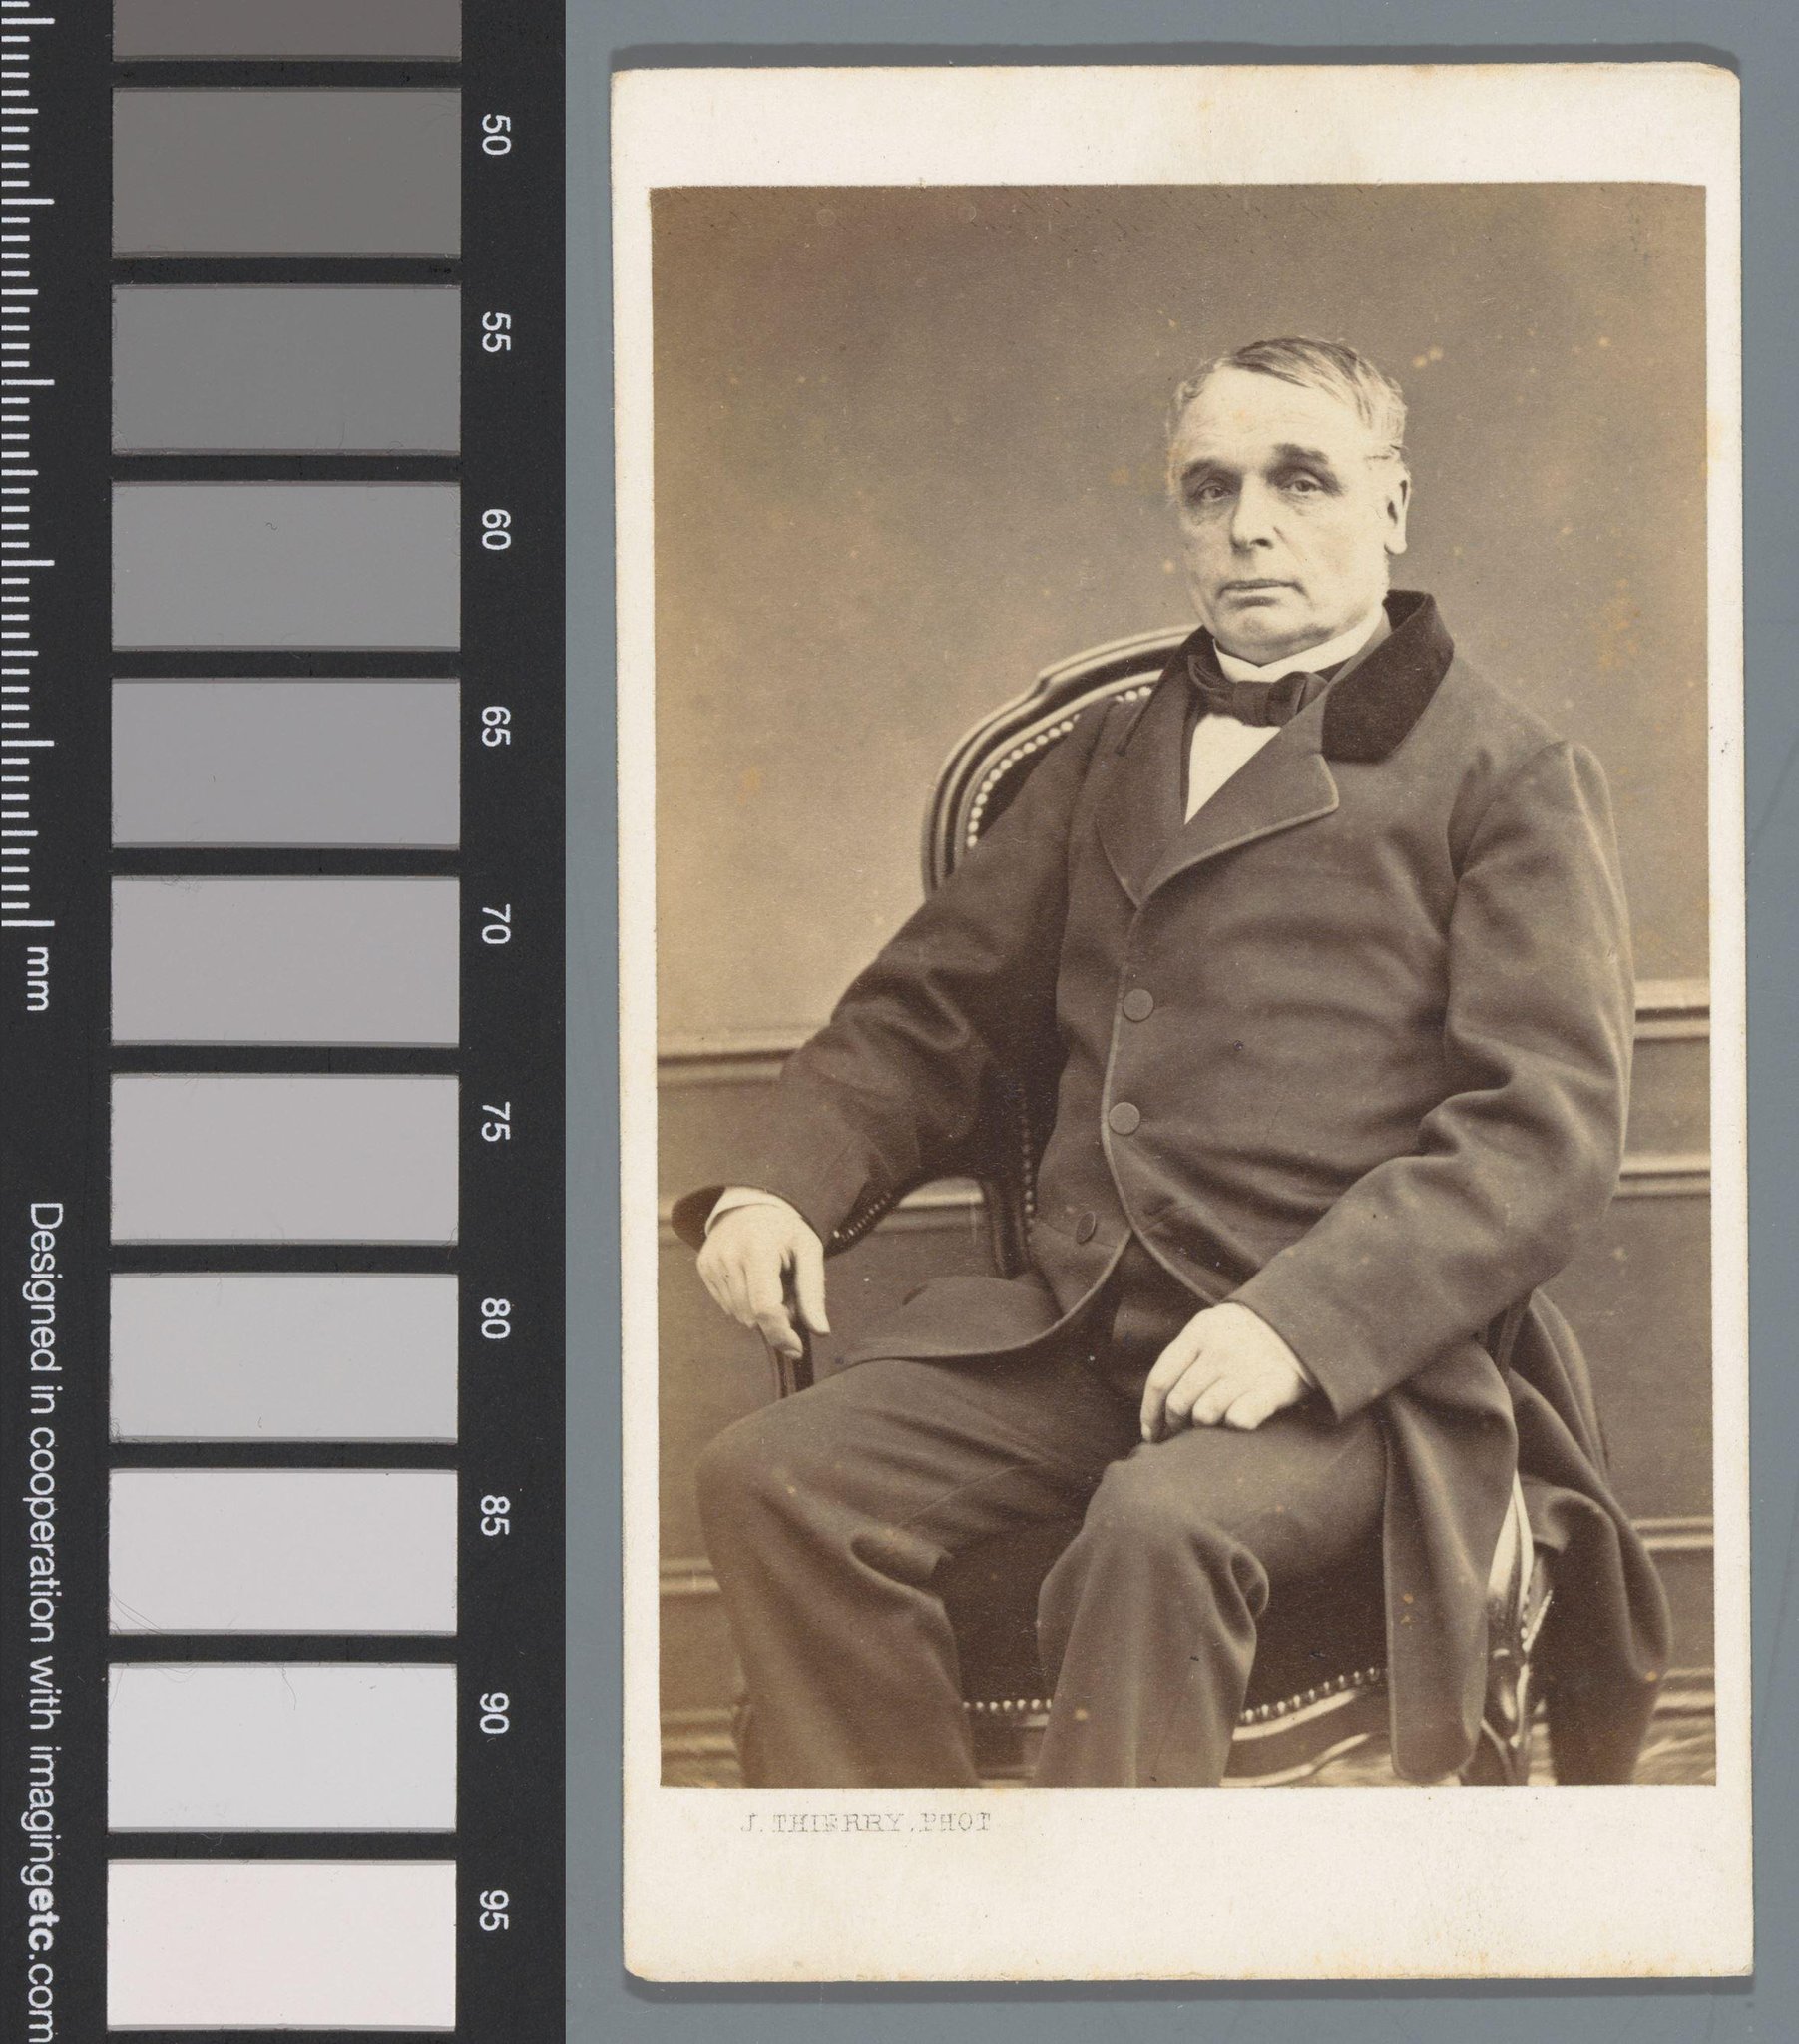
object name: photograph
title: Portret van een onbekende man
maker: jean-pierre thierry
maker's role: fotograaf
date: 1855-1885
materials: cardboard, paper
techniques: albumen print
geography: paris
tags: adult man, anonymous historical person portrayed, paris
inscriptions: inscription: ‘J. Thierry/ de Lyon/ Photographe Médaillé/ de S.M. l'Empereur/ 45, Rue de la Chaussée d'Antin/ Paris’, inscription: ‘J. Thierry. Phot’